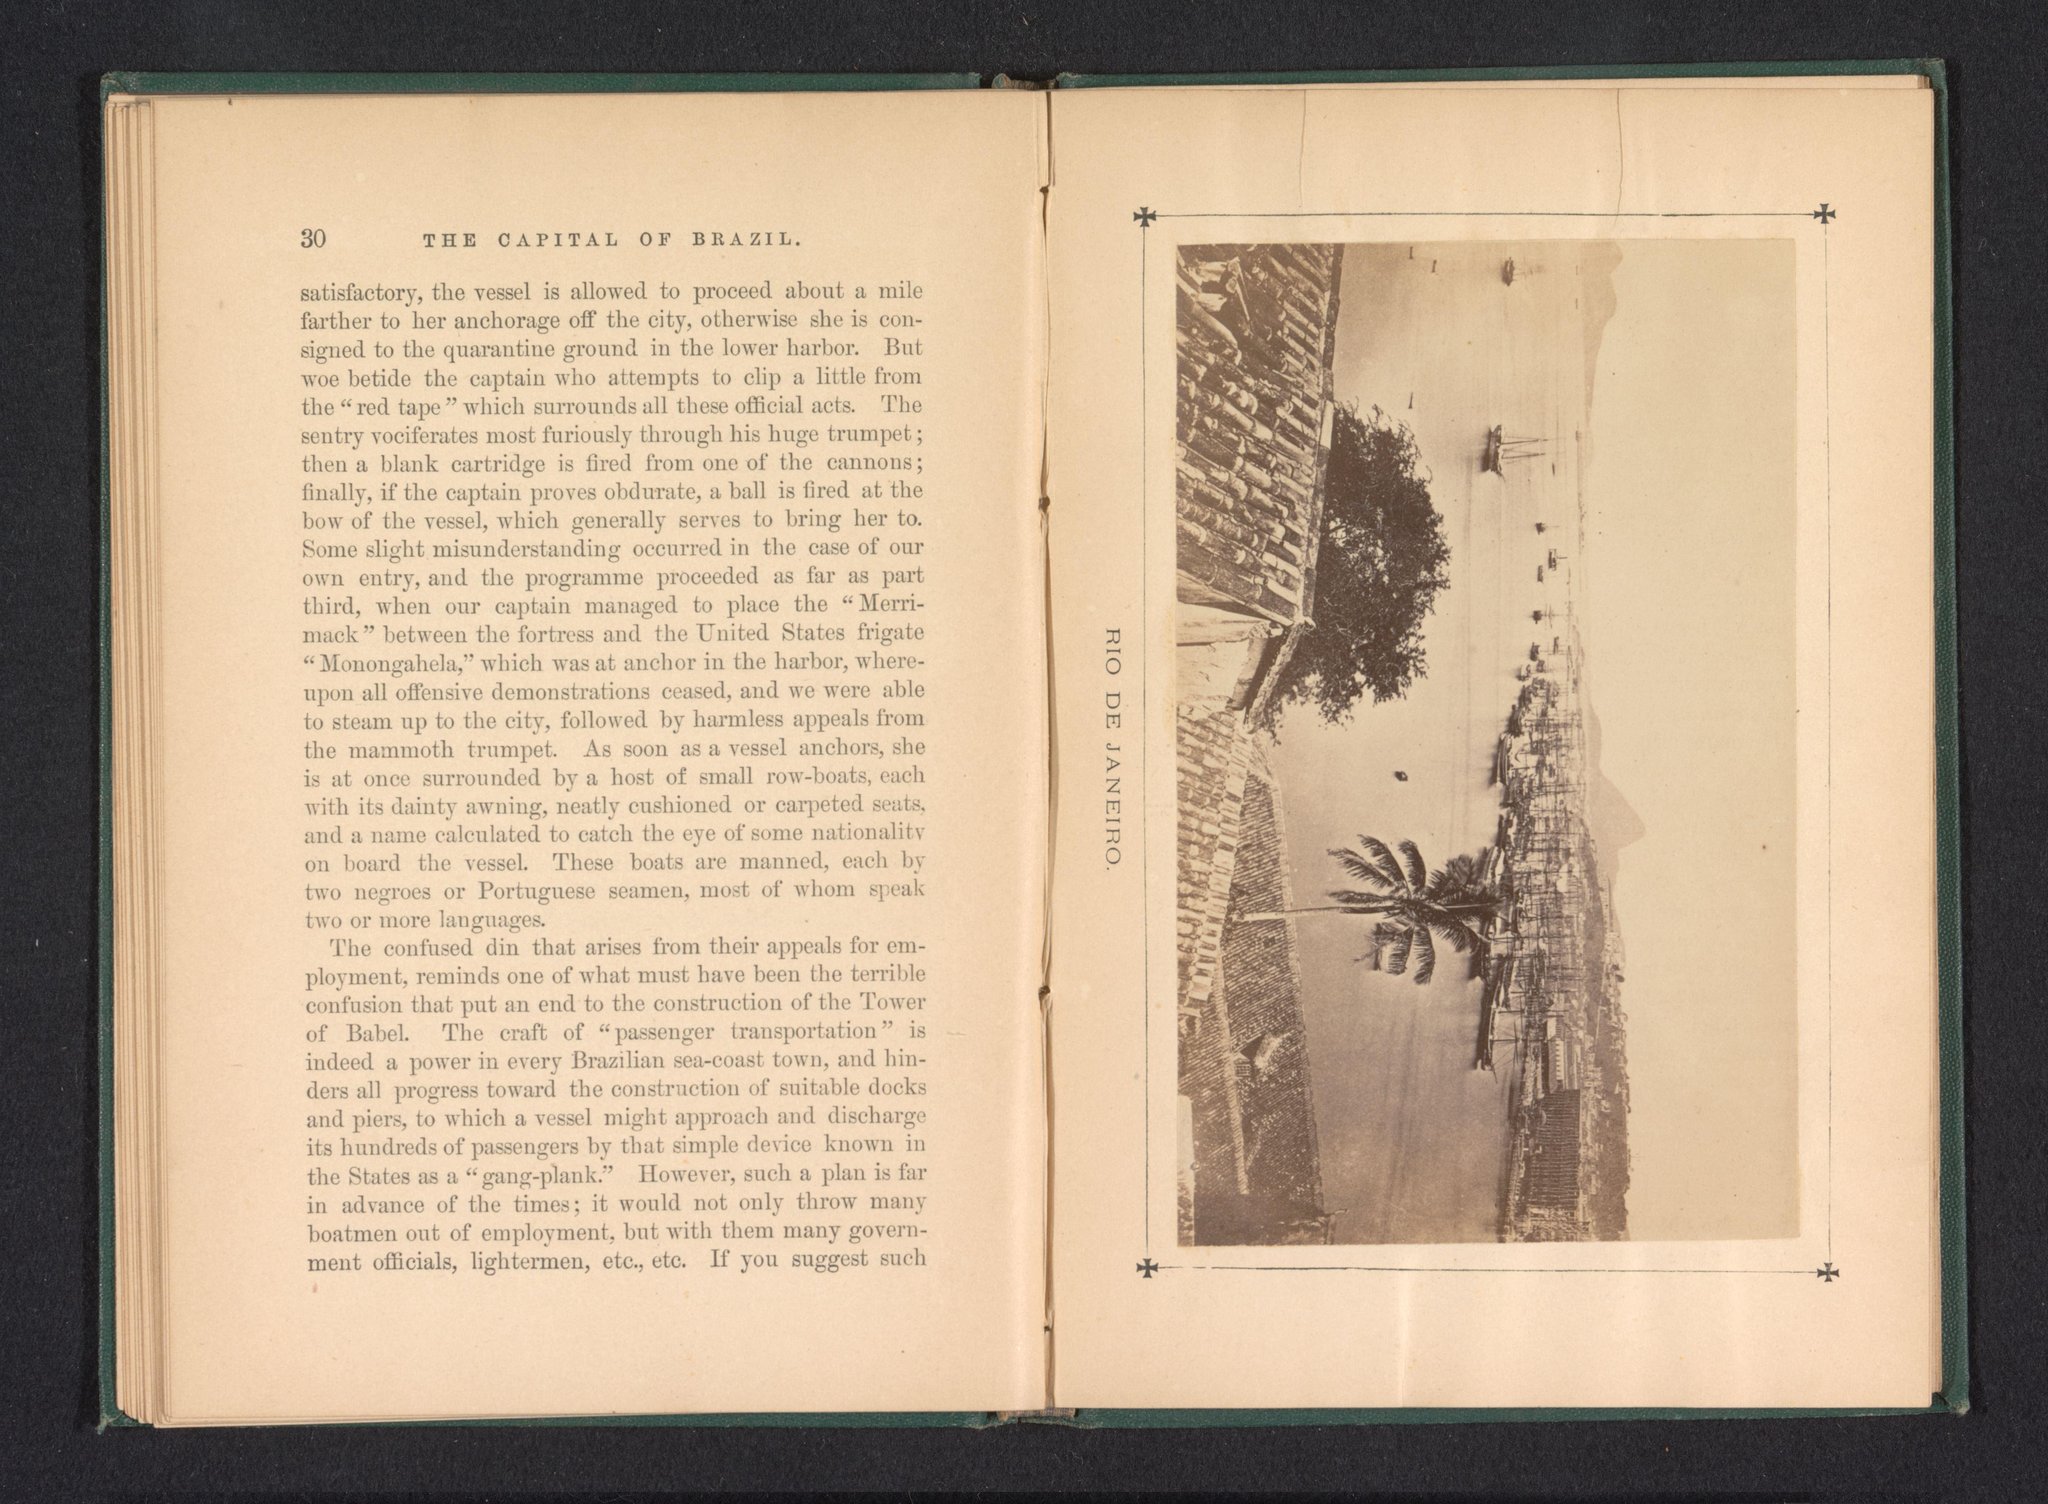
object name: page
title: Gezicht op de haven van Rio de Janeiro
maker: Anonymous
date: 1864-1874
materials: photographic support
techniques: albumen print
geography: rio de janeiro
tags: harbour